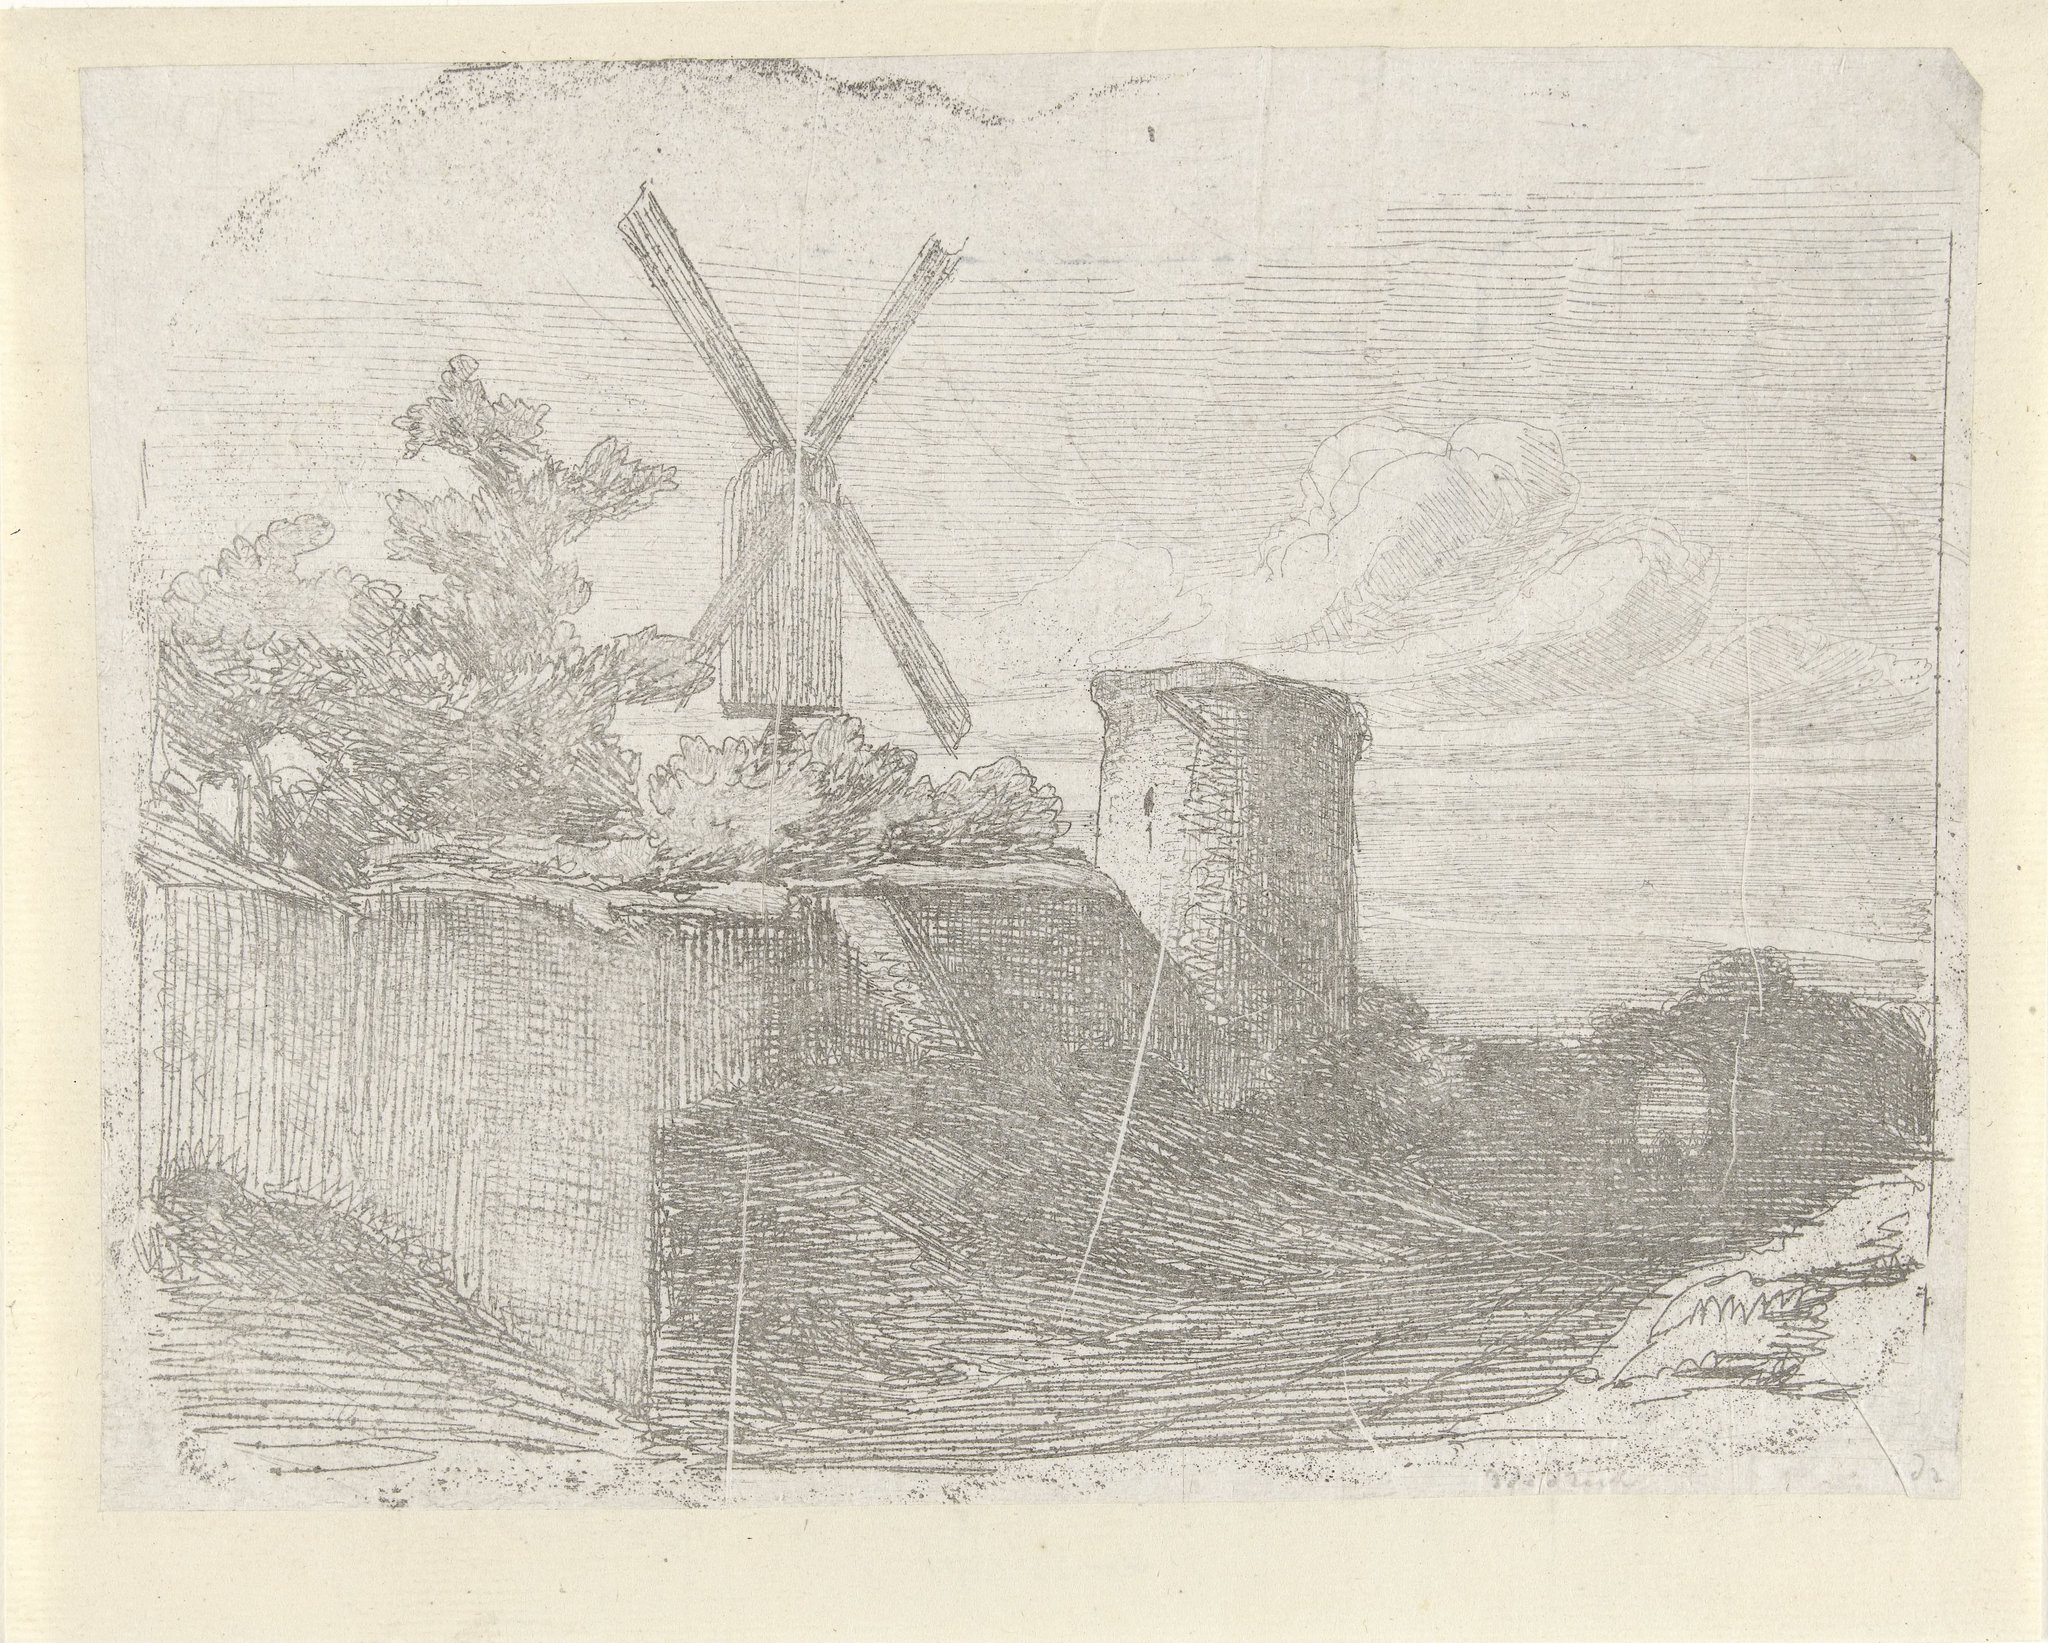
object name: print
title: Ruïne met molen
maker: lambertus hardenberg (1822-1900)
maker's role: draughtsman, painter, print maker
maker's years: 1822-1900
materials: paper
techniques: etching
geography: the hague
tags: landscape with ruins, windmill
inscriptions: collector's mark: Lugt 2228